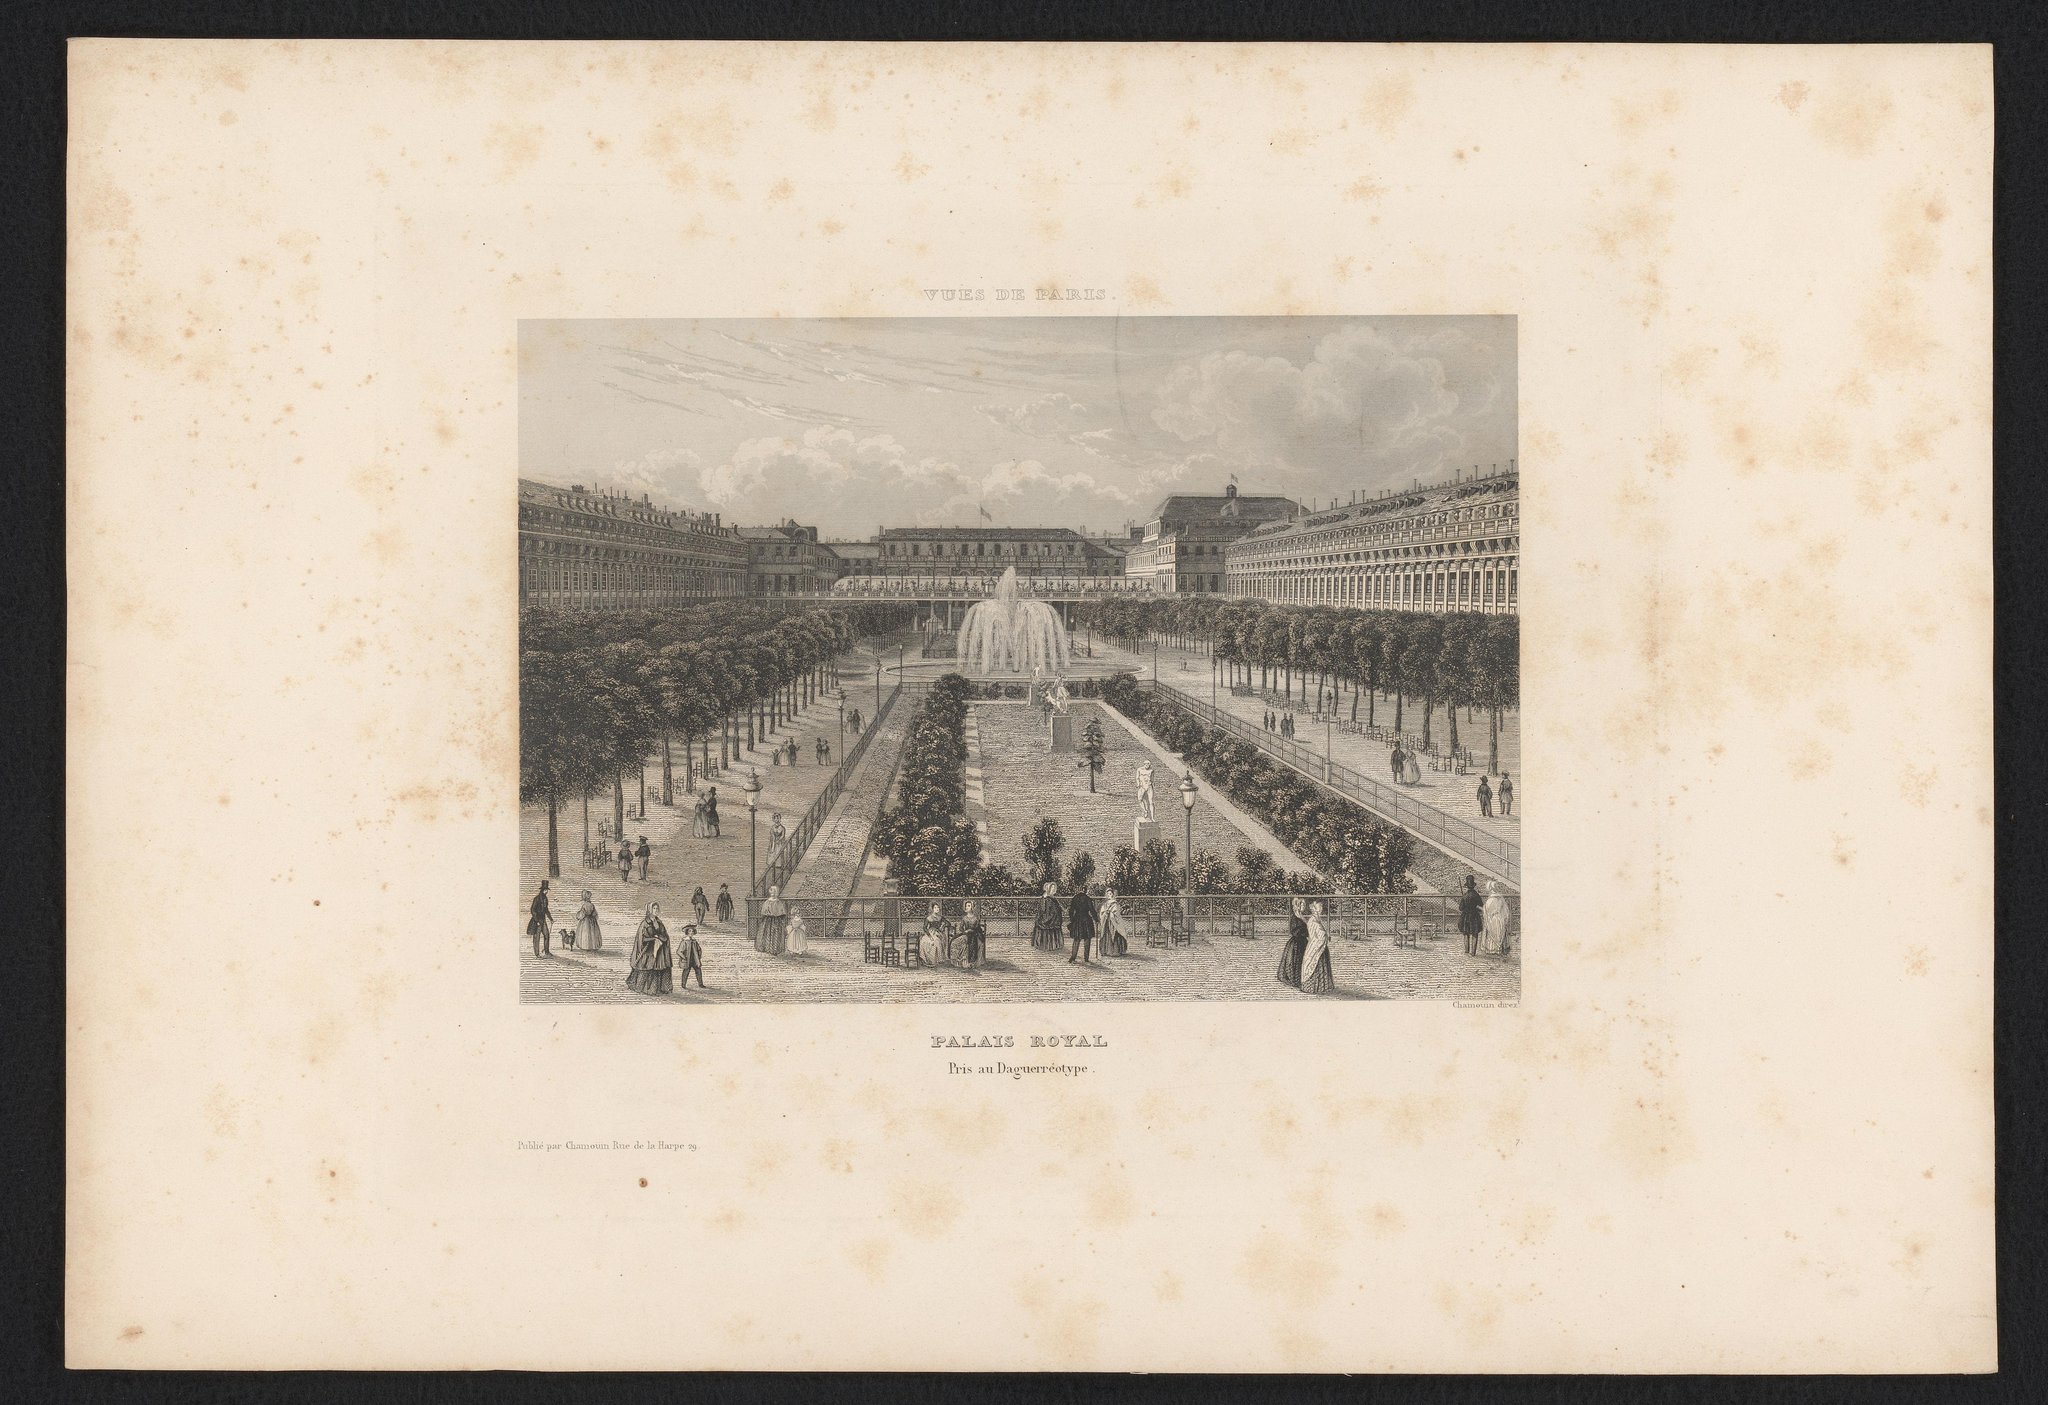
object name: print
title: Gezicht op het Palais-Royal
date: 1845-1850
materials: paper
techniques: engraving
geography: paris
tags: palace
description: Deze prent maakt deel uit van een omslag met 22 prenten op 22 bladen.